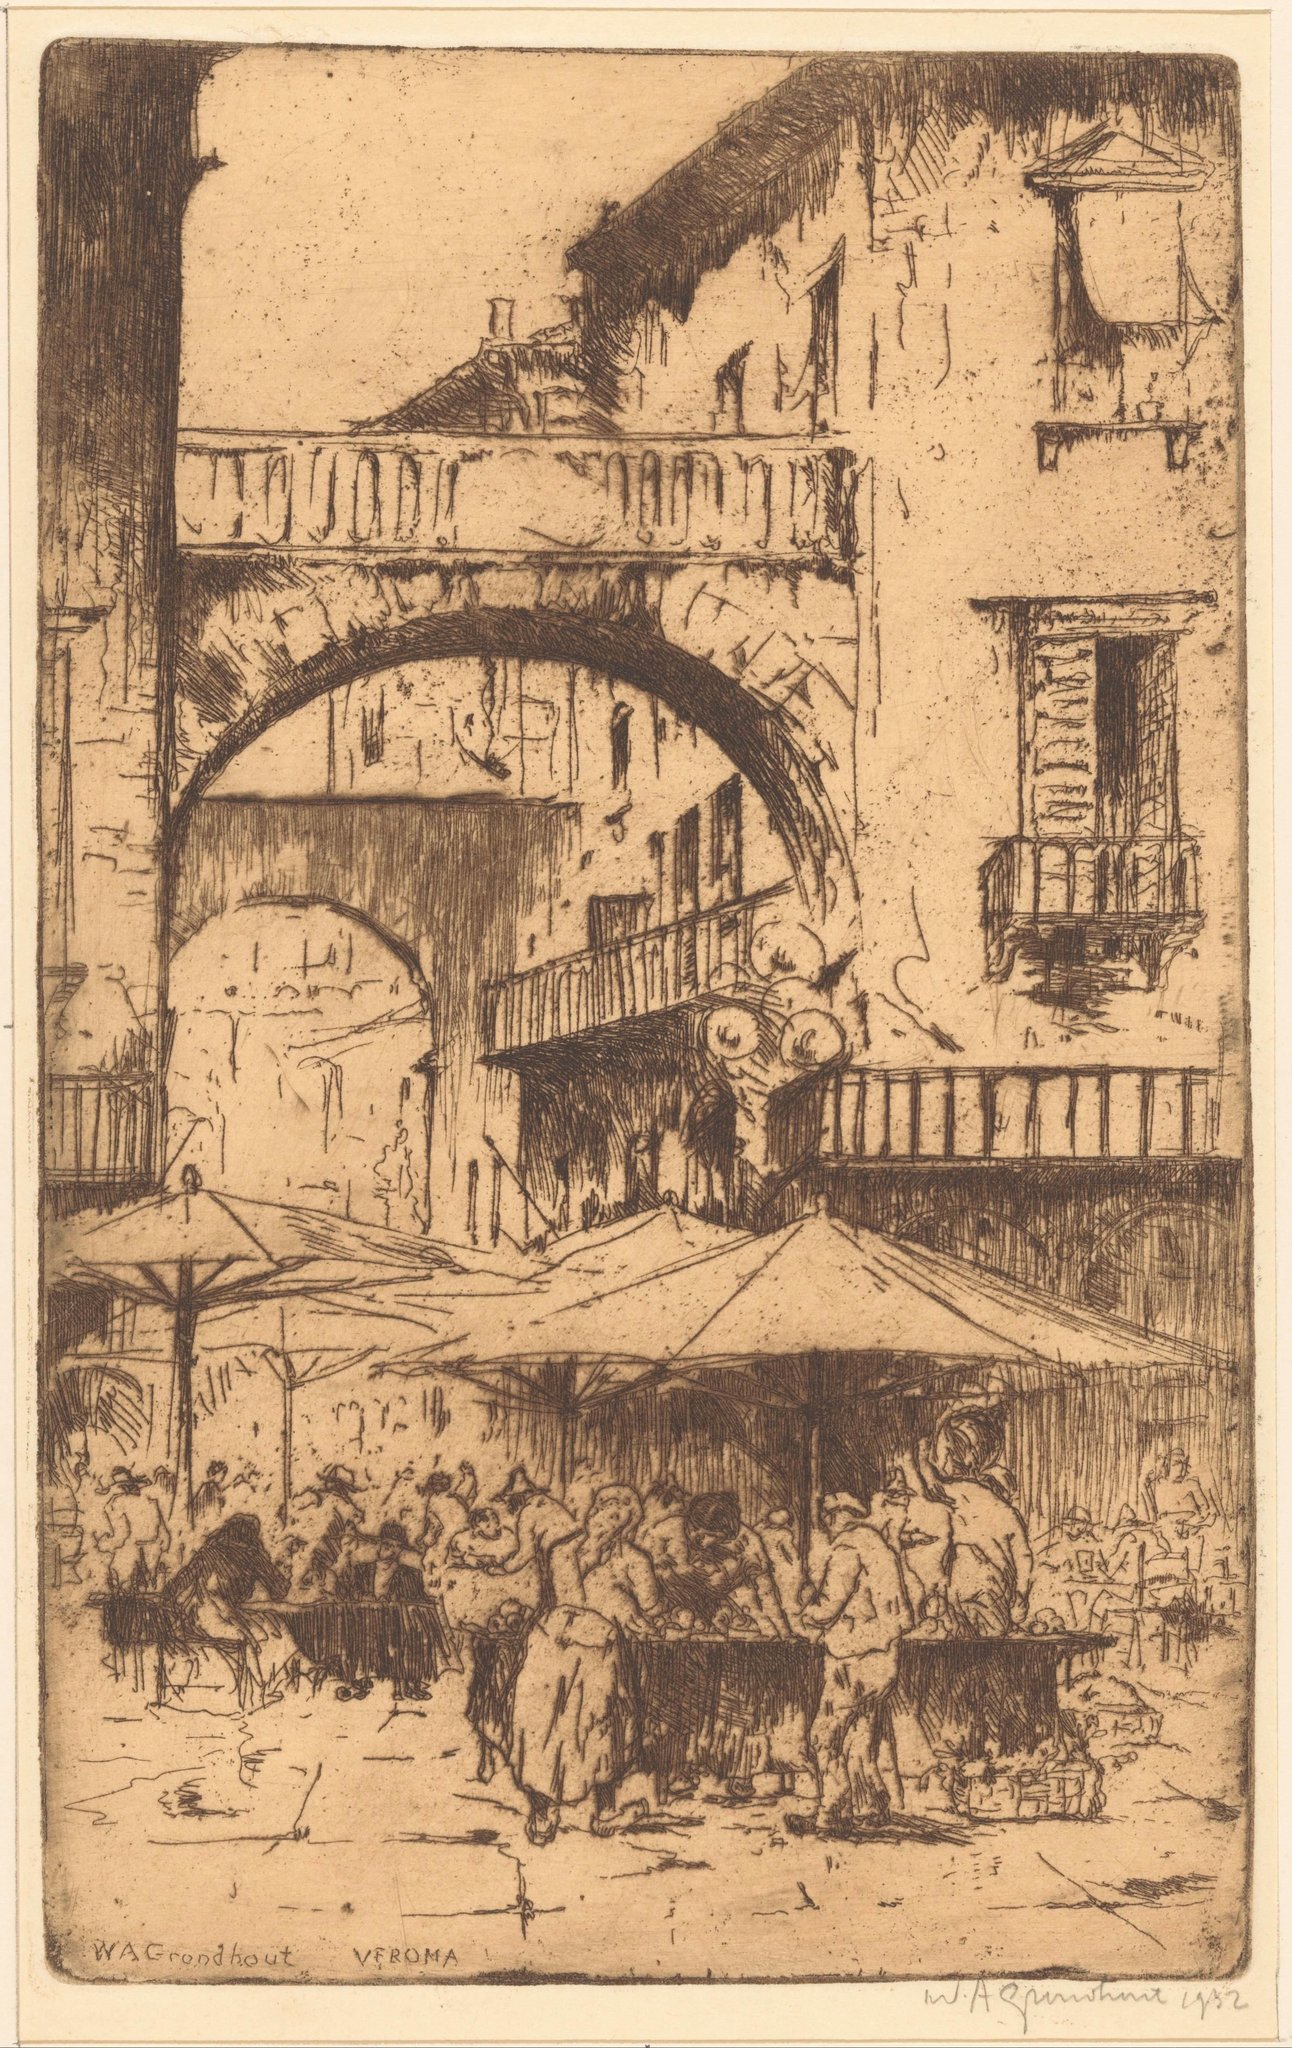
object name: print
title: Verona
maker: willem adrianus grondhout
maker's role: draughtsman, painter, print maker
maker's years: 1878-1934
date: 1932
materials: paper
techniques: etching, intaglio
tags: market, city-gate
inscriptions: collector's mark: Lugt 2228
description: Een straatmarkt in het Italiaanse Verona. Op de achtergrond twee poorten boven een straat.